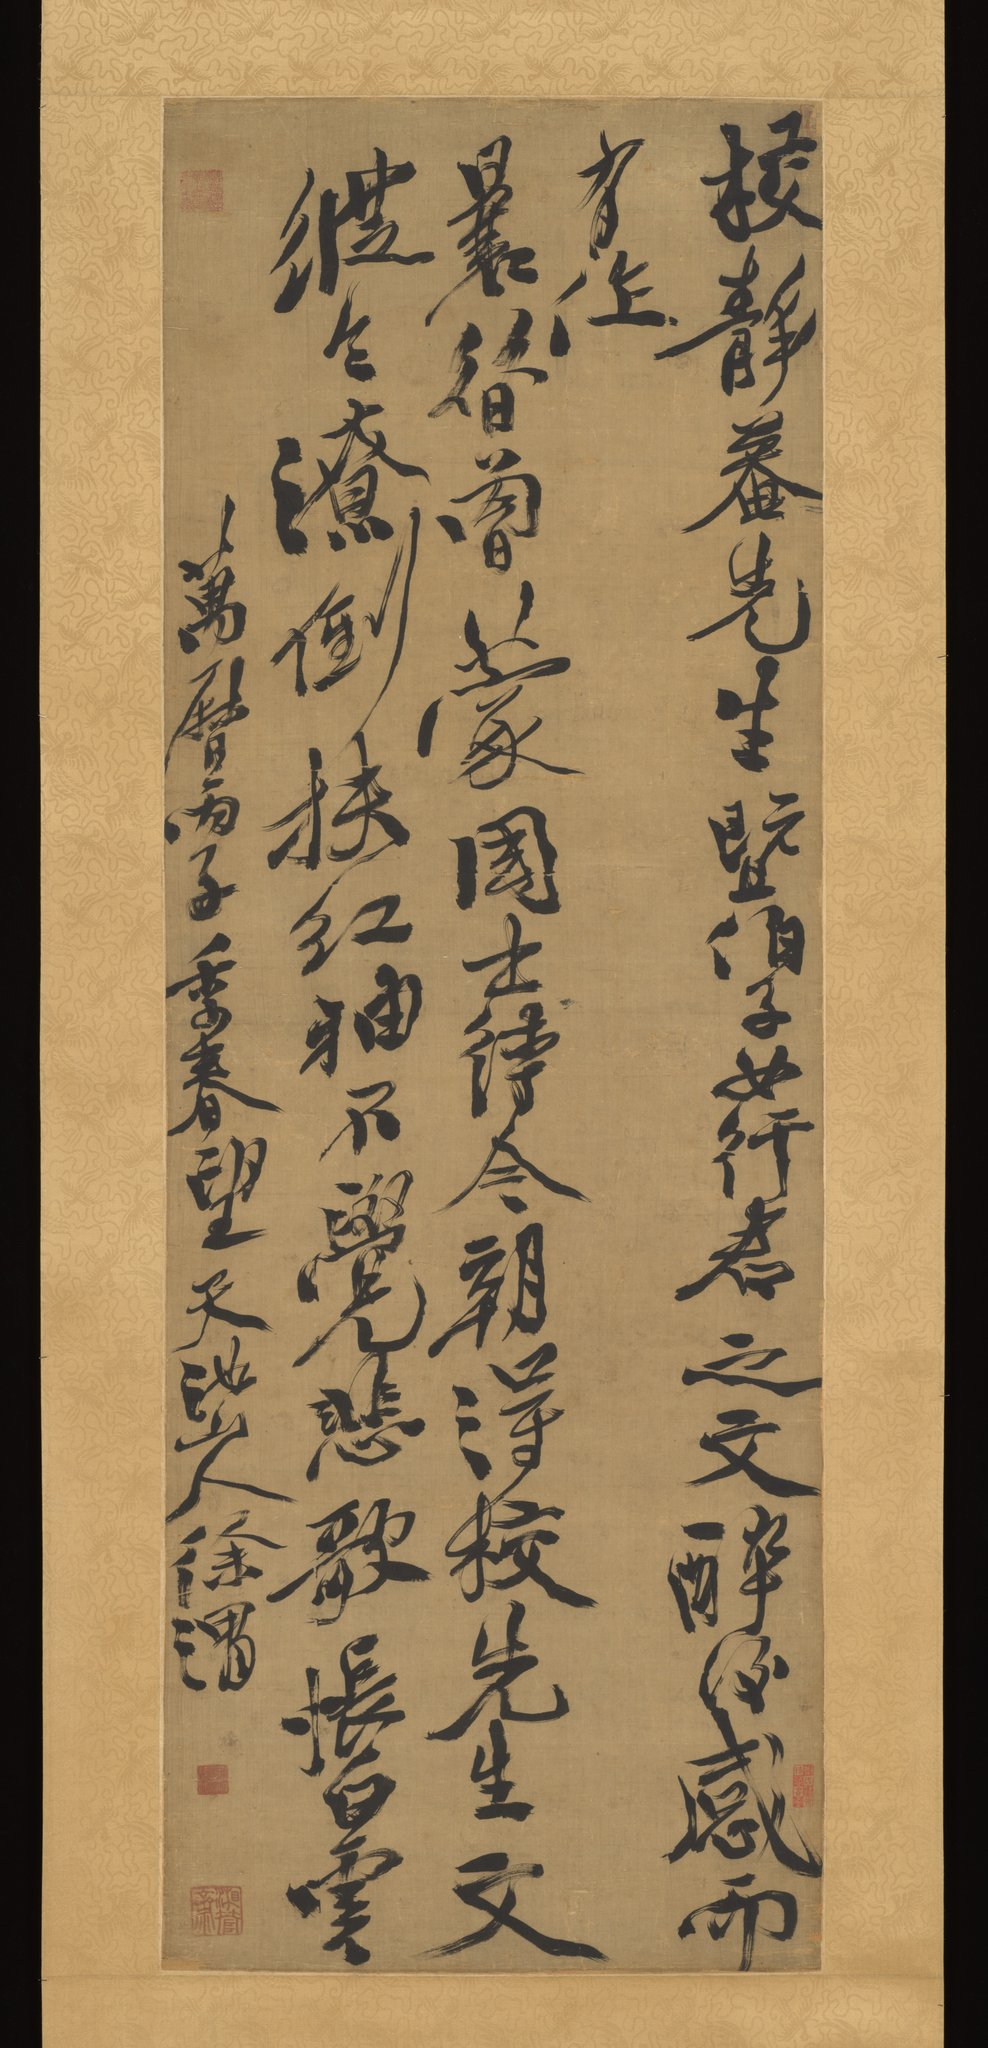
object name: hanging scroll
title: Poem Composed after Editing Jingan's Literary Works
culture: chinese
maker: unidentified artist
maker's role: artist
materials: ink, silk